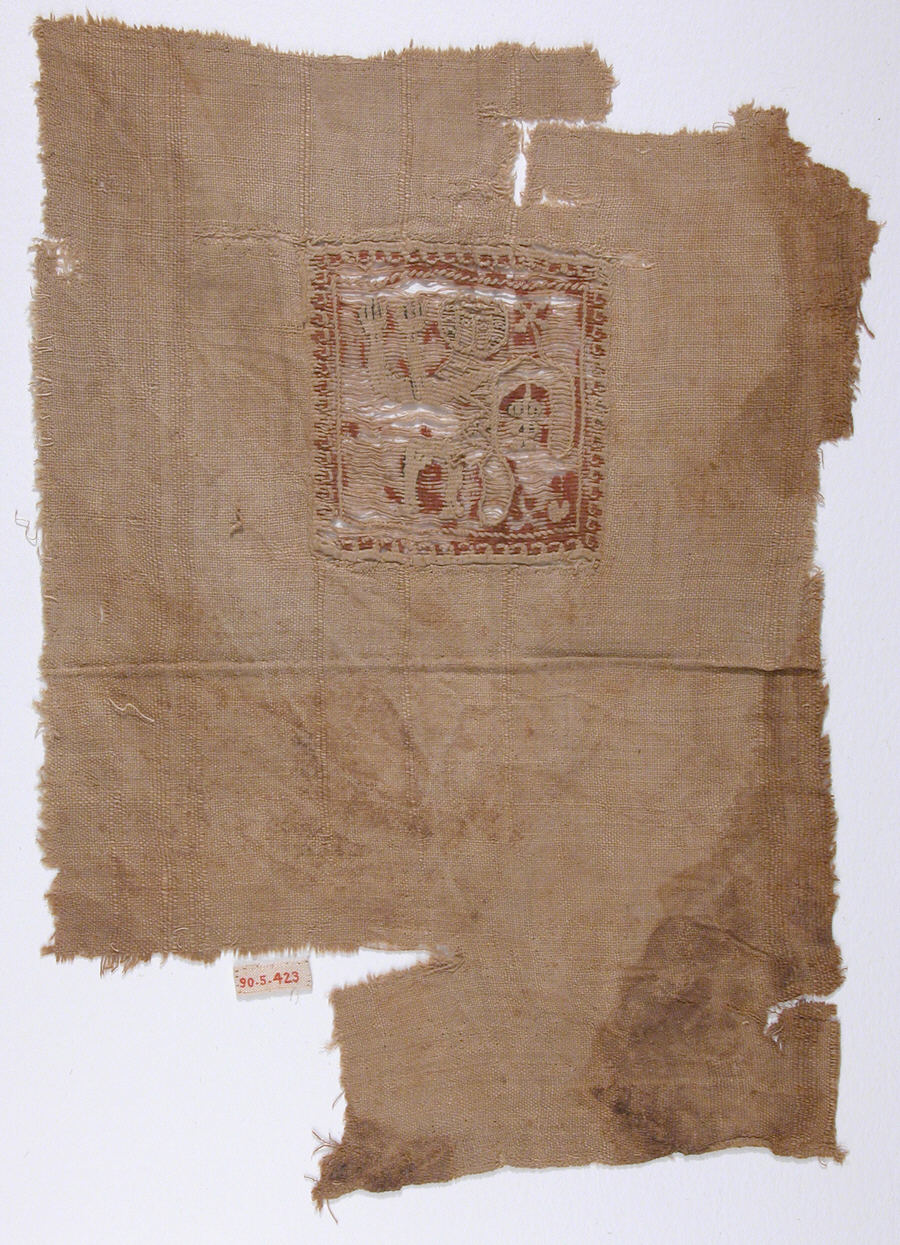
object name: textile fragment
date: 401-500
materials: linen, wool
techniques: weave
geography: egypt